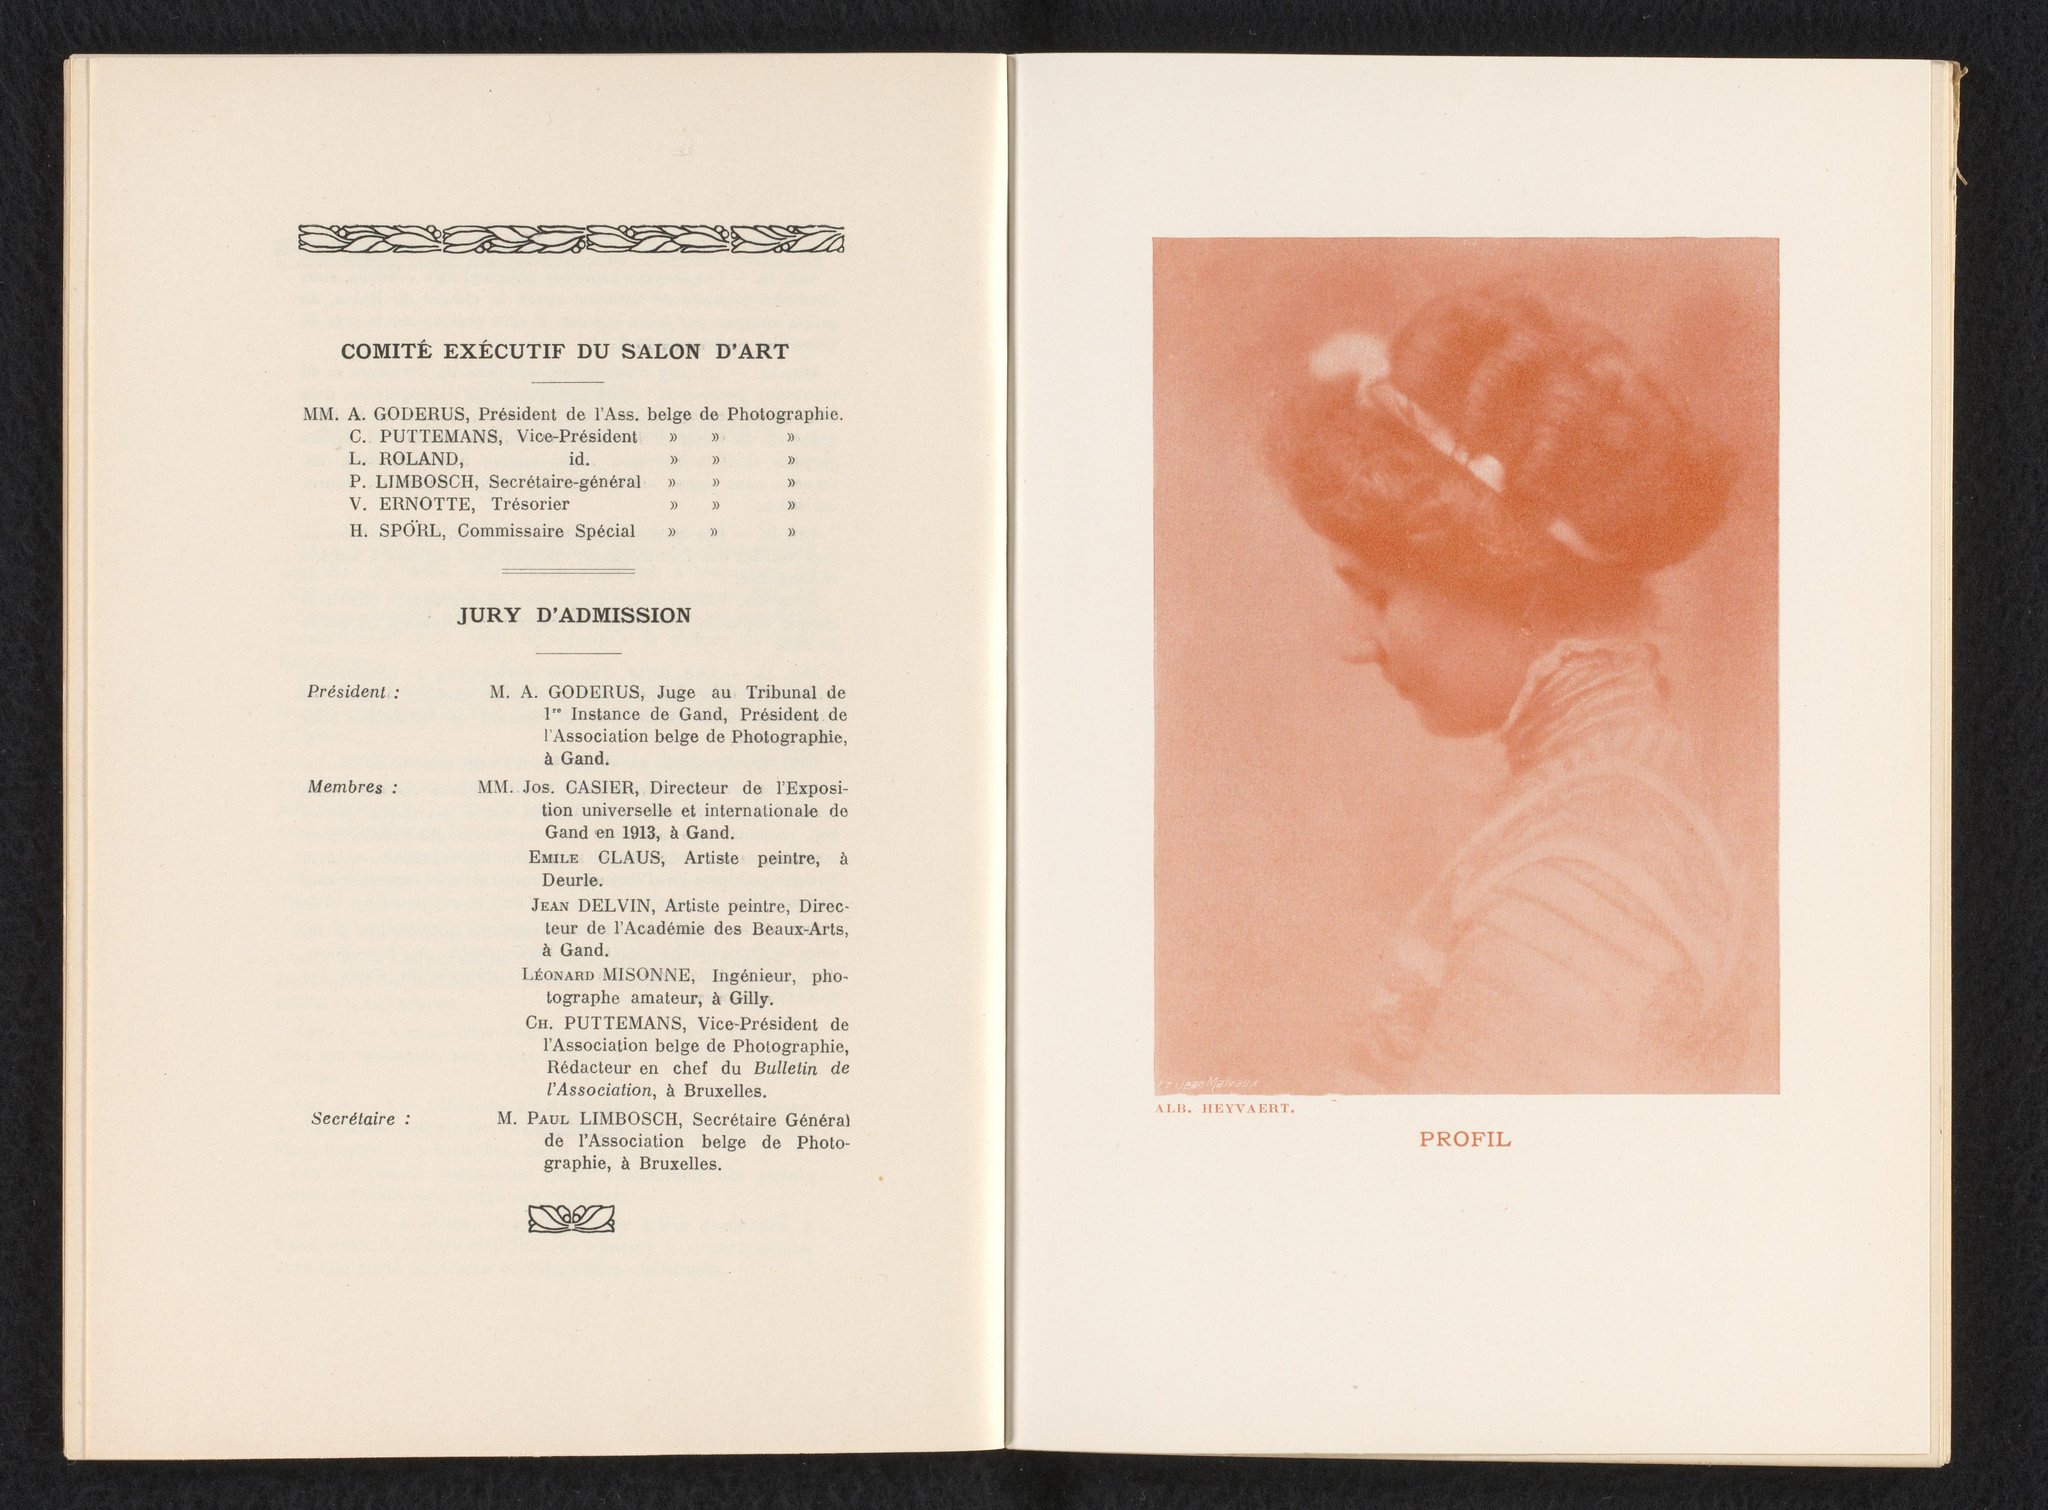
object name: page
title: Portret van onbekende vrouw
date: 1908-1913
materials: paper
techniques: autotype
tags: anonymous historical person portrayed alone - bb - woman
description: Prent op tweede ongenummerde pagina na pagina 15.